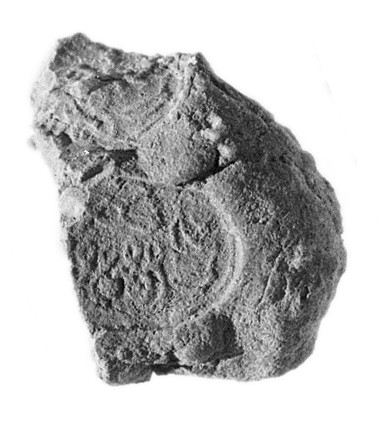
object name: sealing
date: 1981-1640 BCE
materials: mud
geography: egypt